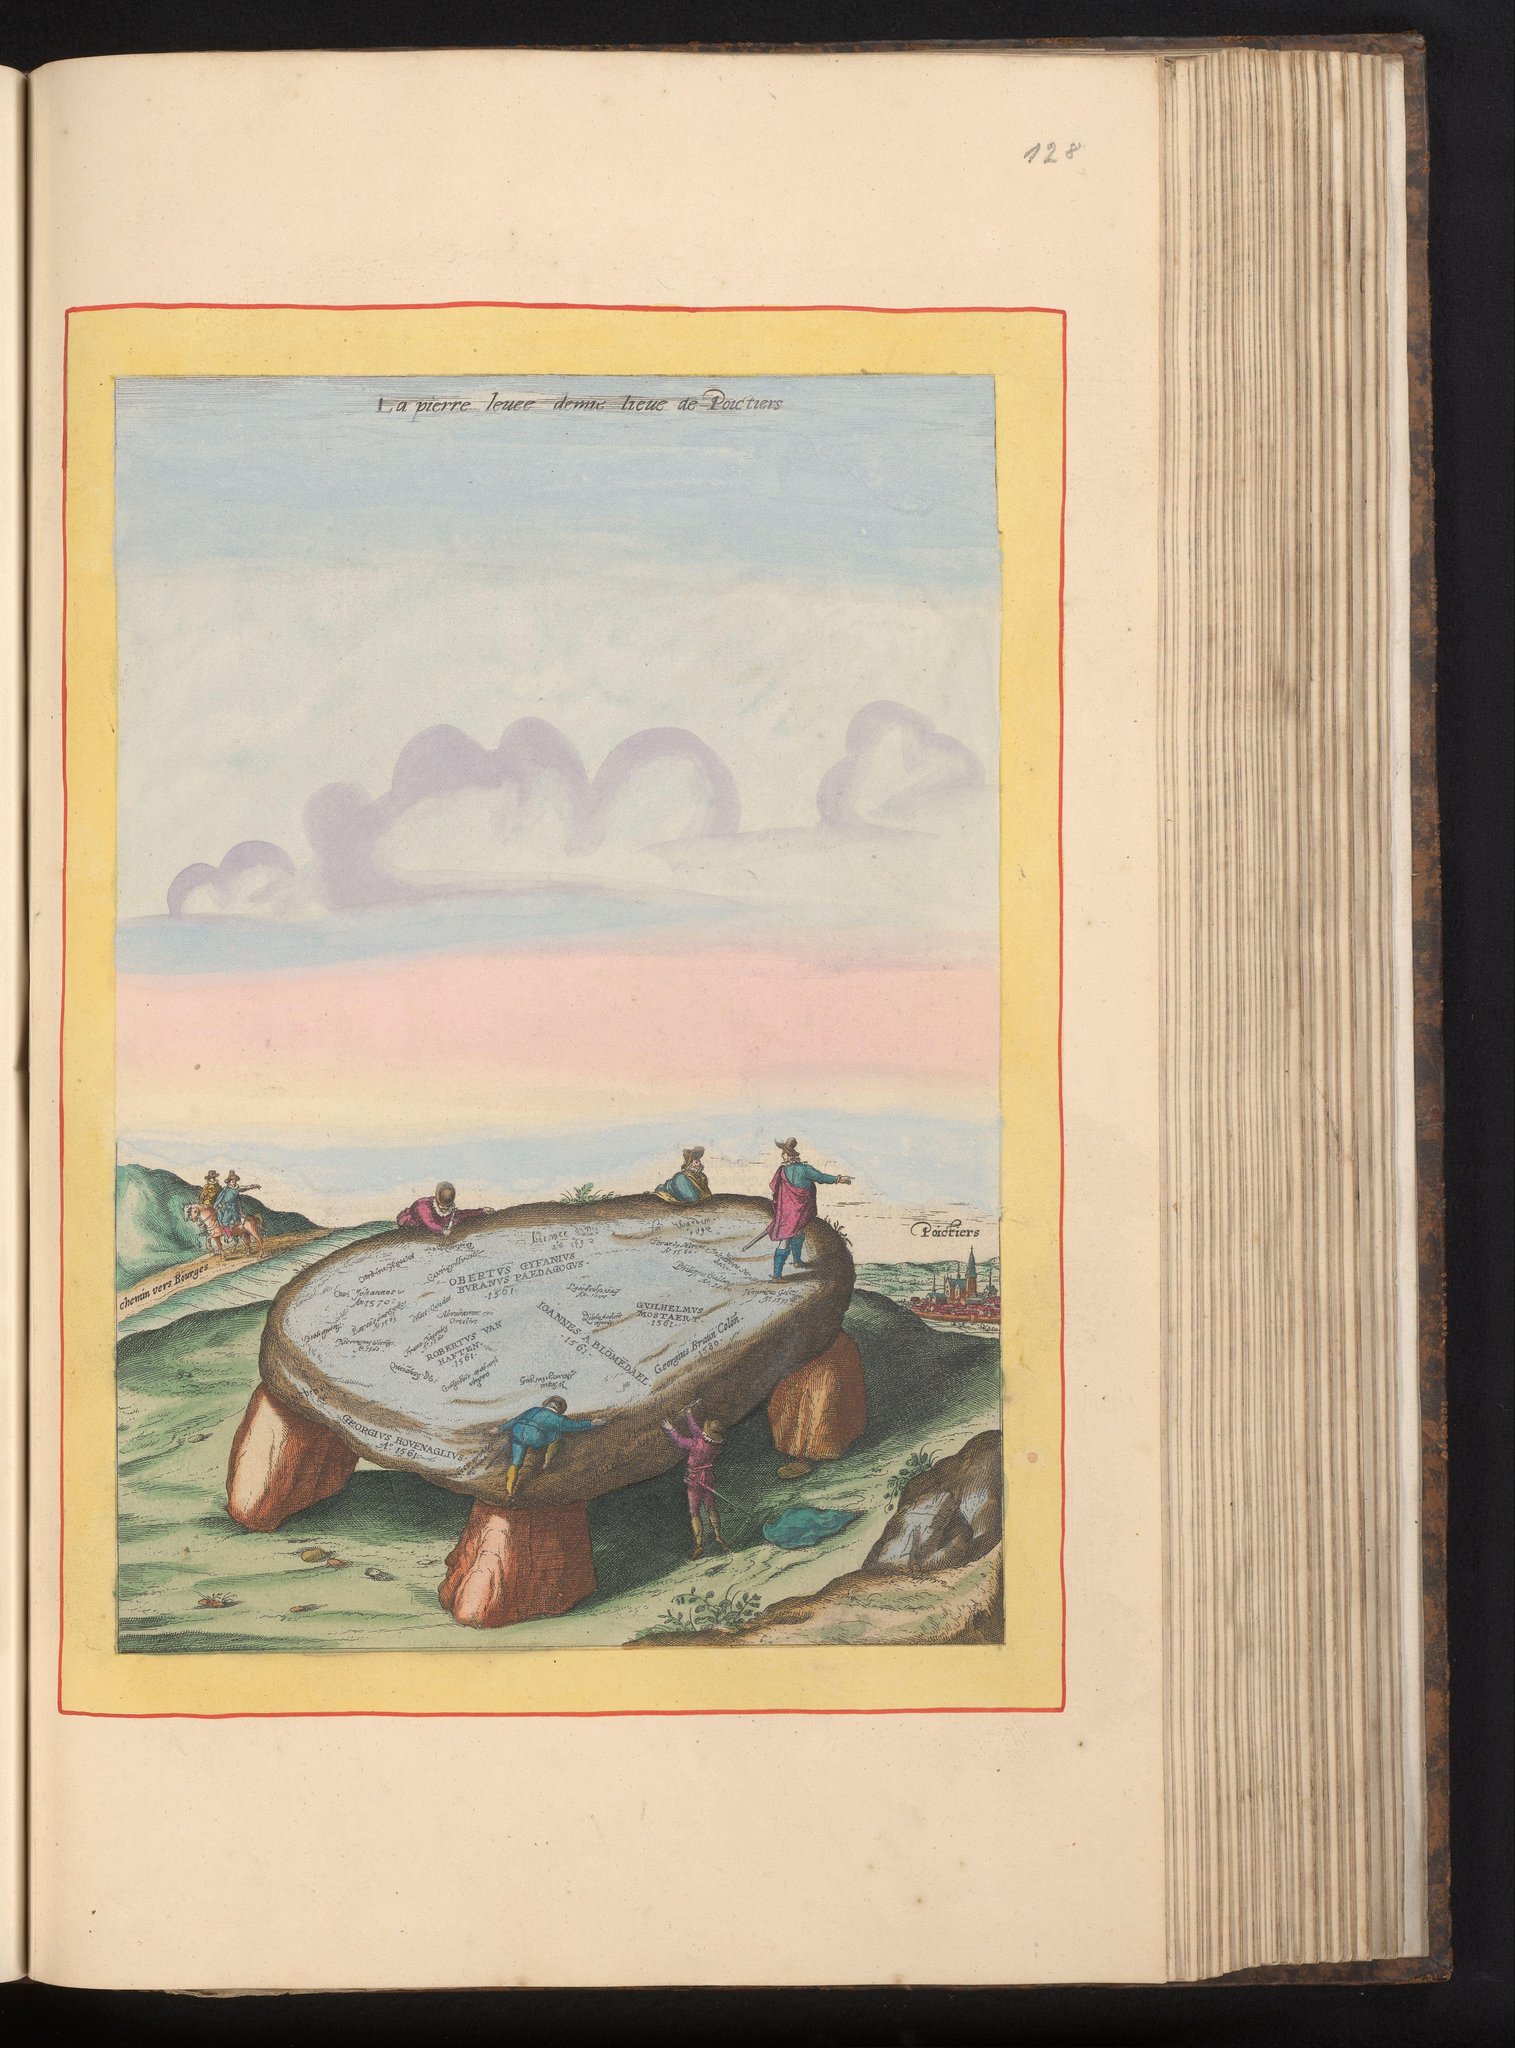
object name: print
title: Gezicht op de dolmen La Pierre-Levée bij Poitiers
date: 1596-1682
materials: paper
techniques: engraving, etching, hand coloring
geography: the hague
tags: megalithic chambered tomb, dolmen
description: Deze prent is in een aantal atlassen gebruikt. Onder andere in: Braun, Georg & Franz Hogenberg. Civitates orbis terrarum. S.l.s.n., 1596-1597, en in: Theatrum exhibens celebriores Galliae et Helvetae urbes. Amsterdam: Johannes Janssonius, 1657, en in: Tooneel der vermaarste koop-steden. Amsterdam: erven Johannes Janssonius van Waesberge, 1682. Deze prent is origineel gedrukt van één plaat met een gezicht op Henrichemont en een gezicht op Poitiers (RP-P-1956-218).